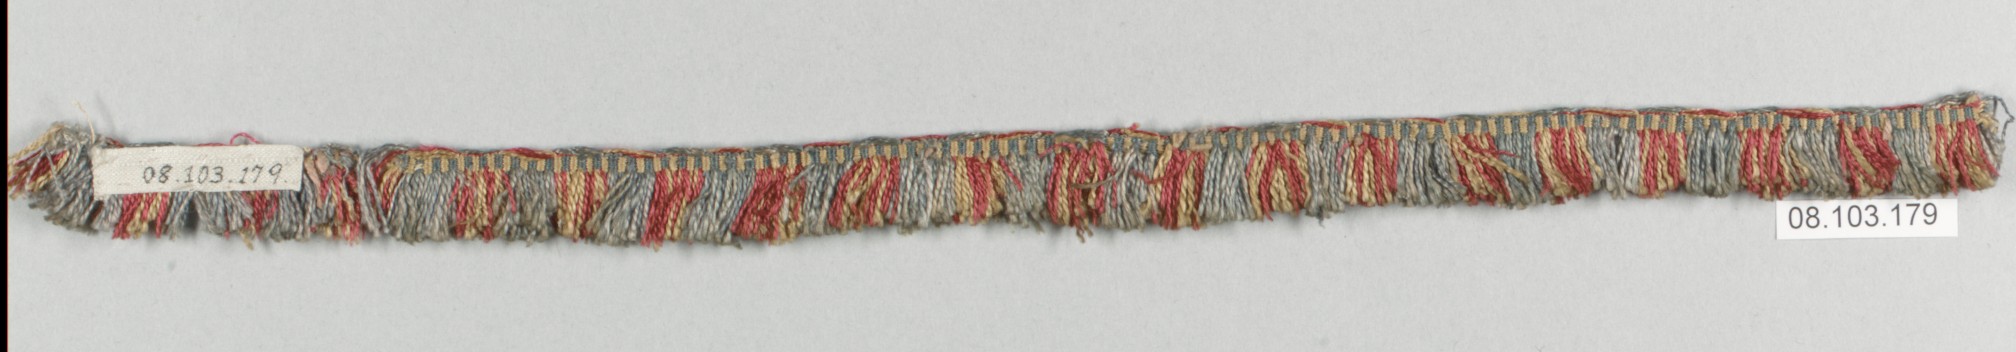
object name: fringe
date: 1801-1900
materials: silk